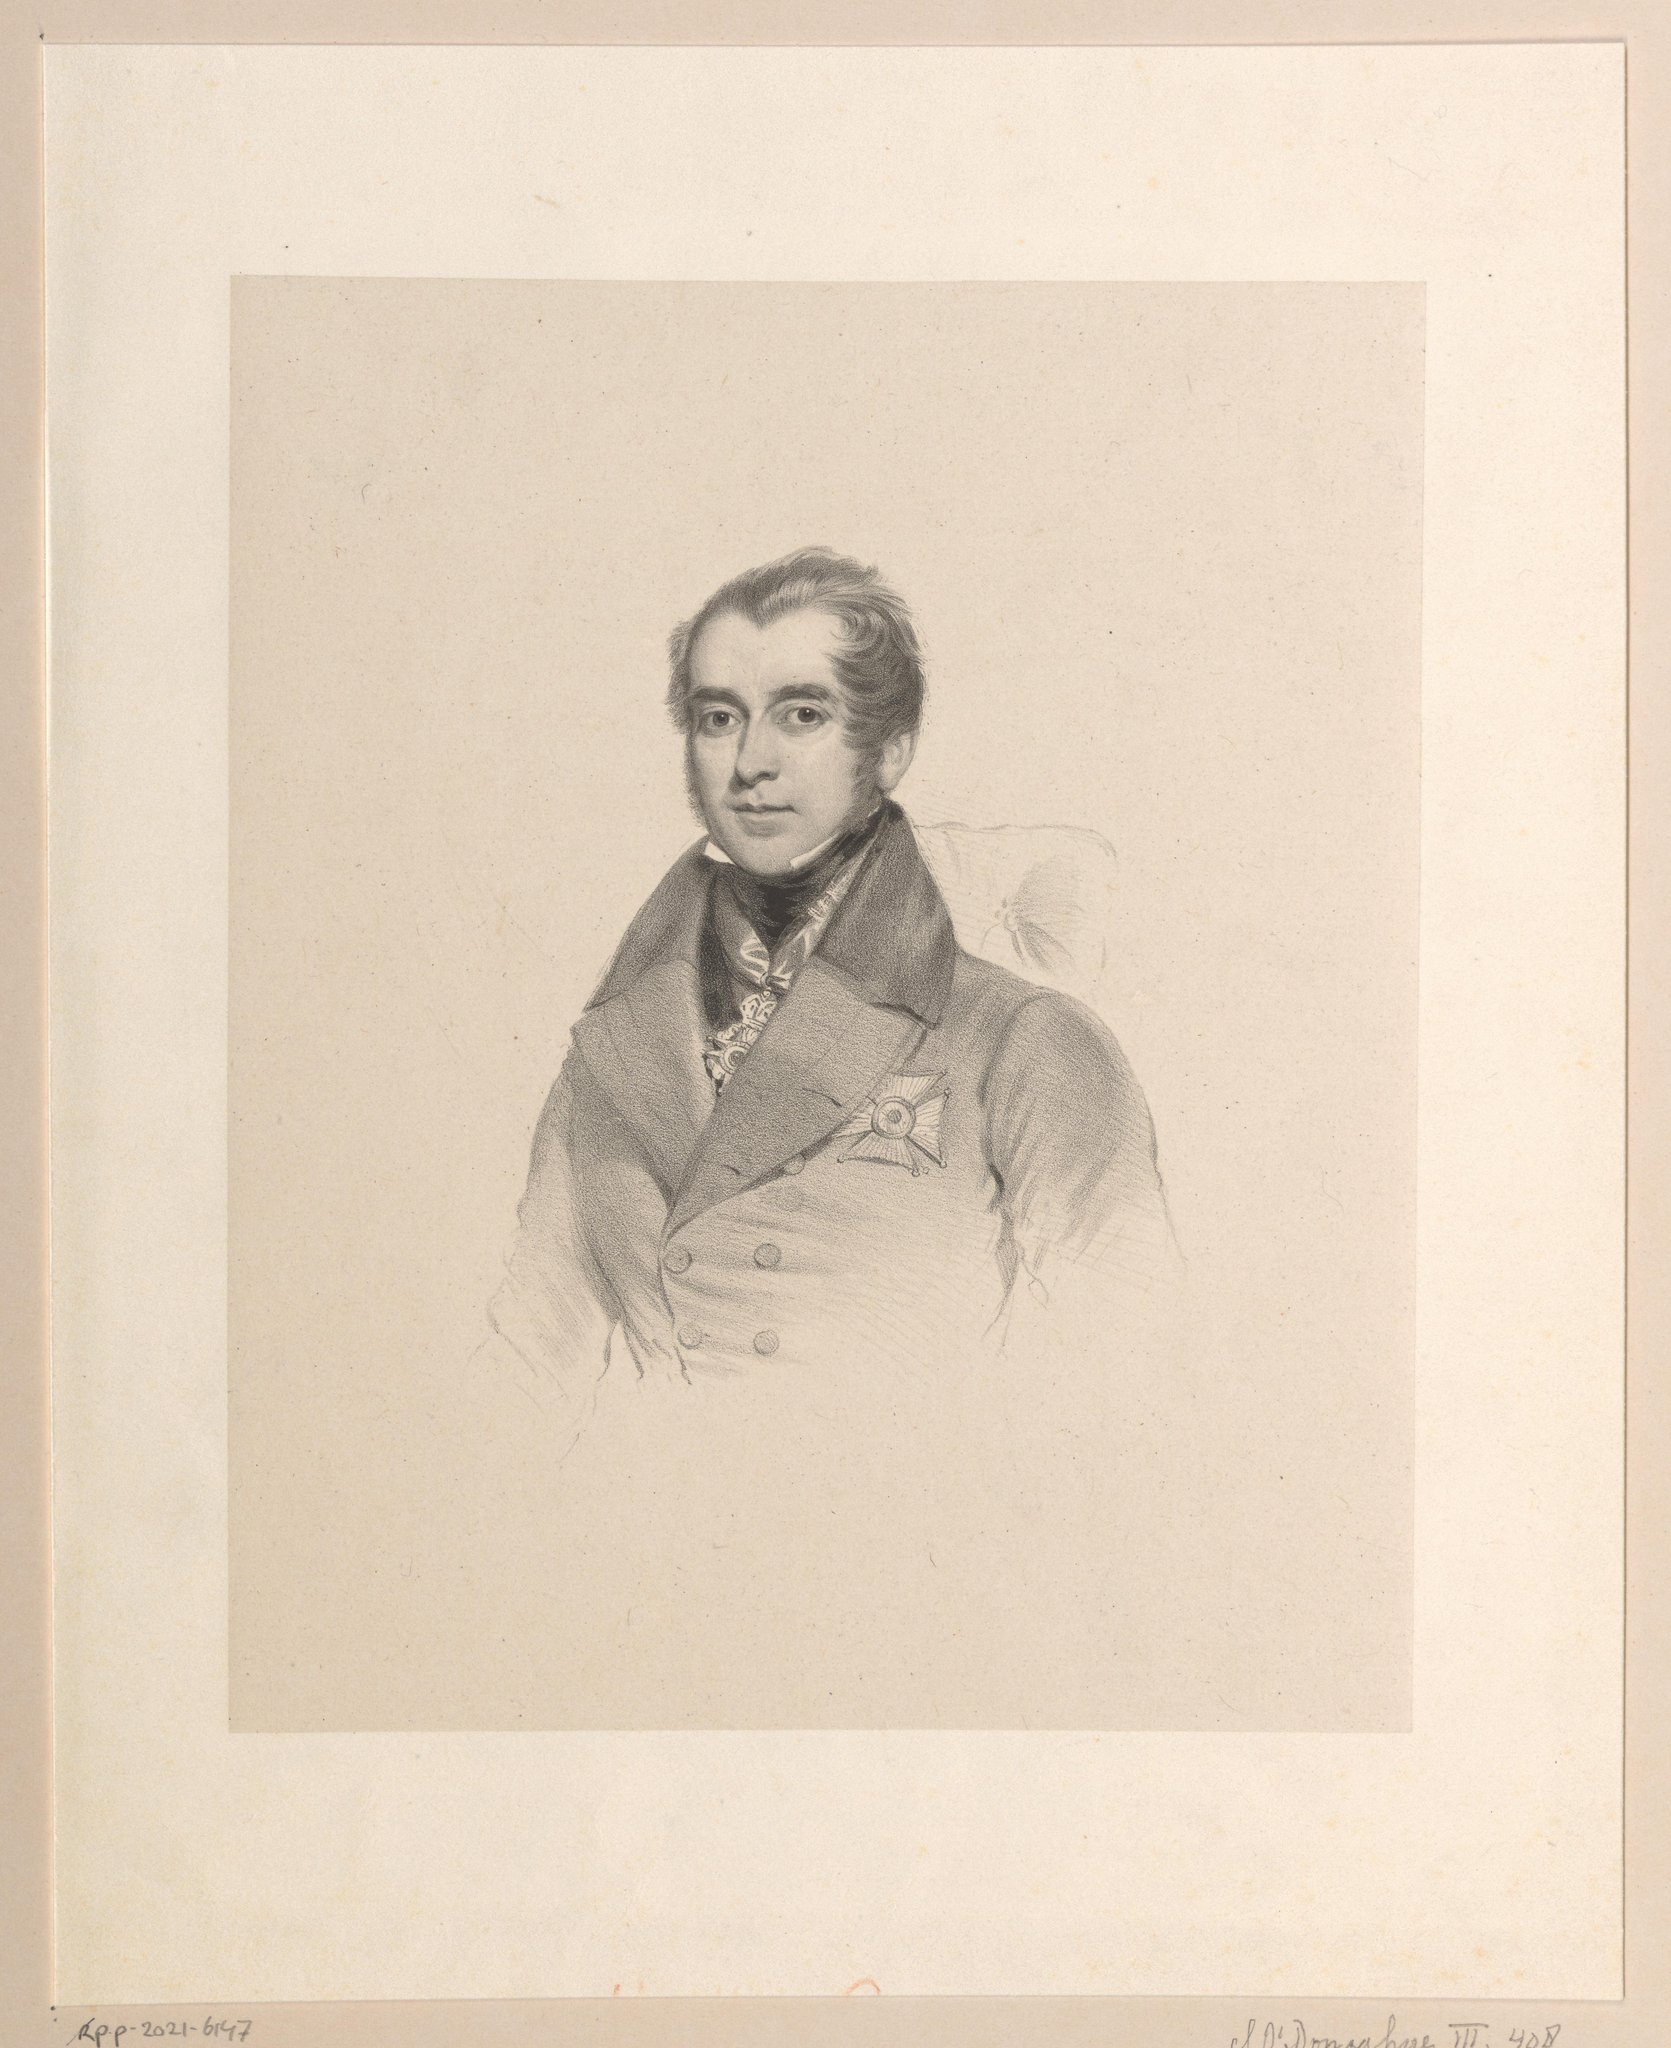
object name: print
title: Portret van Woodbine Parish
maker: Anonymous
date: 1825-1899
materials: paper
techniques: lithograph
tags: adult man, historical persons